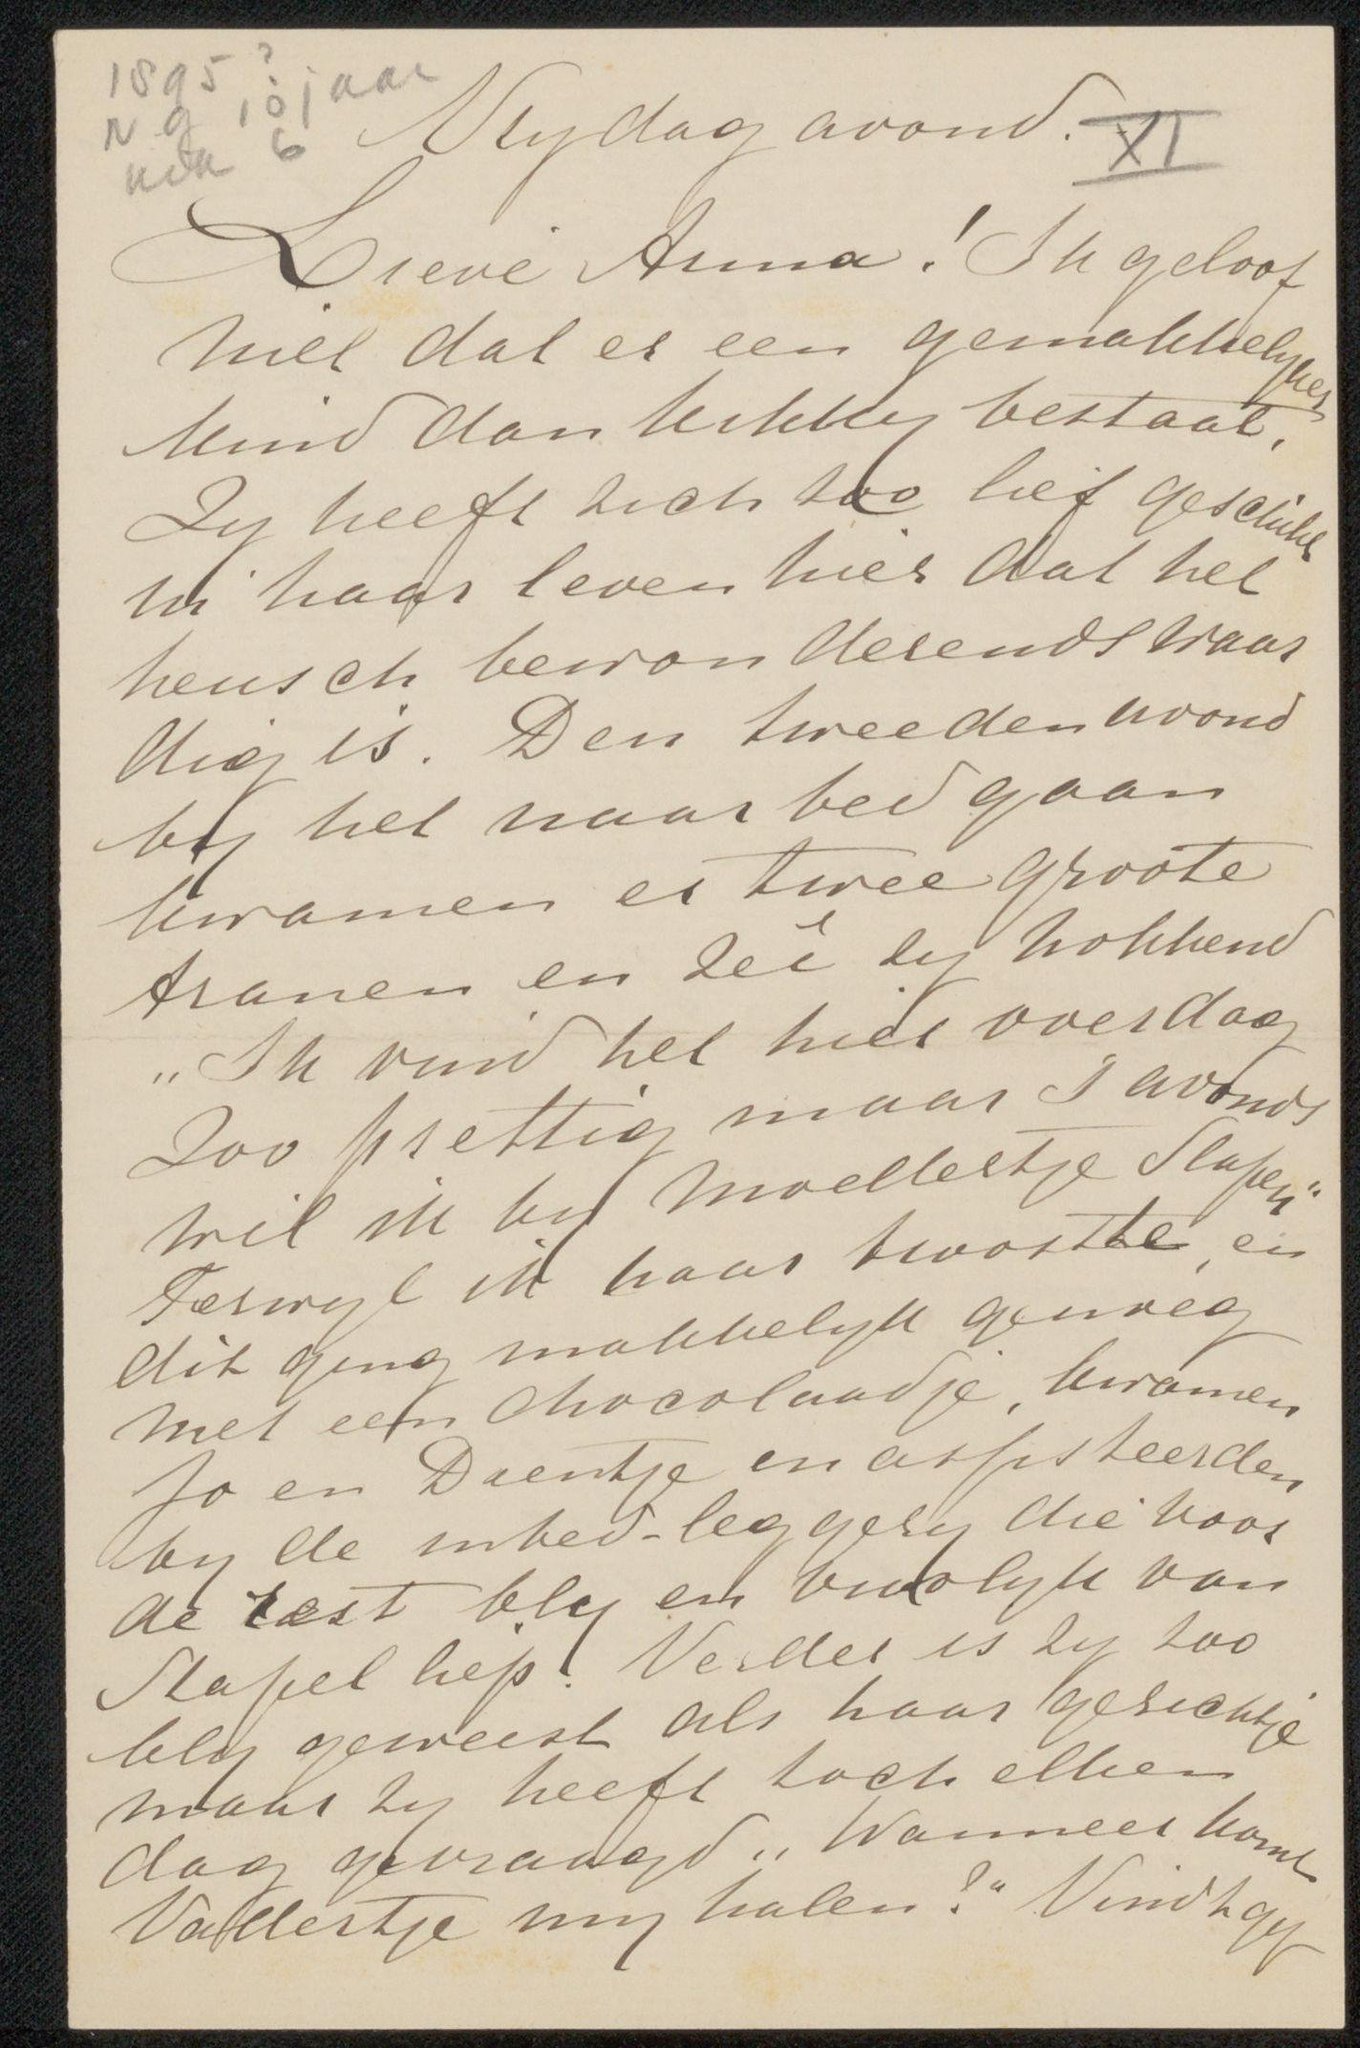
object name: letter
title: Brief aan Anna Dorothea Dirks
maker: jacoba cornelia jolles-singels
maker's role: schrijver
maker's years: 1847-1901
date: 1873-1901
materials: ink, paper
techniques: pen, writing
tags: haarlem, print maker, anton molkenboer, willem kloos, artist, anna dorothea dirks, amsterdam, hein boeken, andré jolles, family life, diseases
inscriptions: collector's mark: ‘RPK’